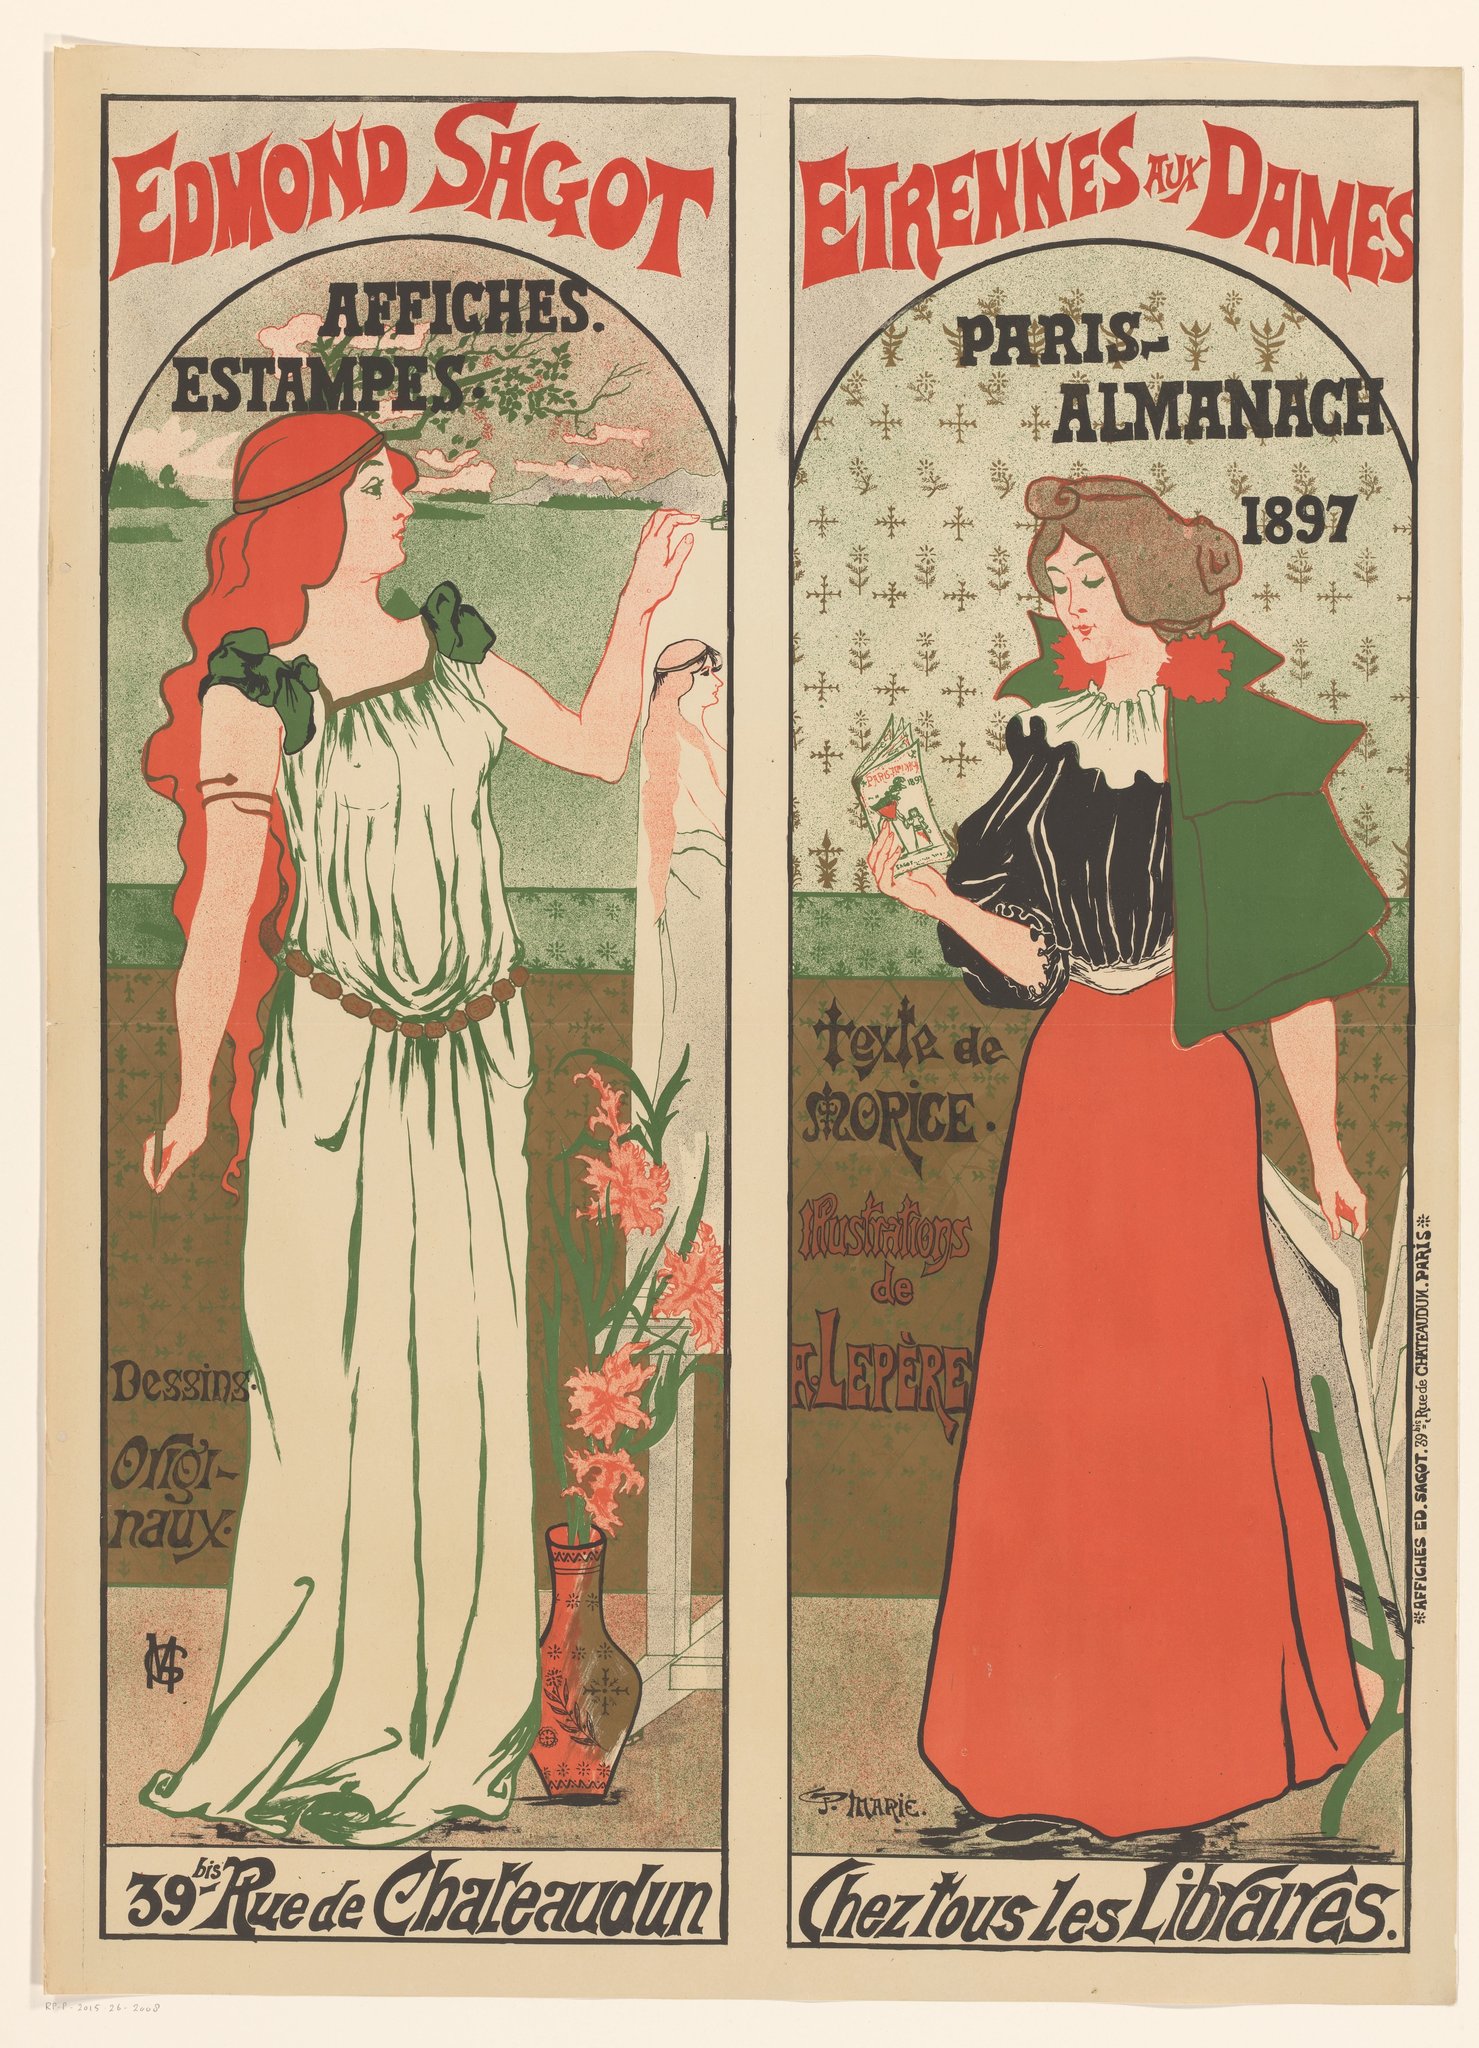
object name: print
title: Edmond Sagot etrennes aux dames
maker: edmond sagot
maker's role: publisher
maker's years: 1857-1917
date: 1897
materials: paper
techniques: lithograph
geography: paris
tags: calendar, almanac, tools, implements of draughtsman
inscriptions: collector's mark: Lugt 2228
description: Links maakt een vrouw gekleed in een Griekse chiton reclame voor de affiches en prenten die Sagot verkocht. In haar rechterhand houdt deze vrouw een krijthouder; haar linkerhand rust op een zelfportret. Naast haar staat een vaas met bloemen. De vrouw links draagt moderne kleding en maakt reclame voor de Paris-Almanach, waarvan ze een exemplaar in haar rechterhand heeft. Haar linkerhand rust op een prent in een prentstandaard.